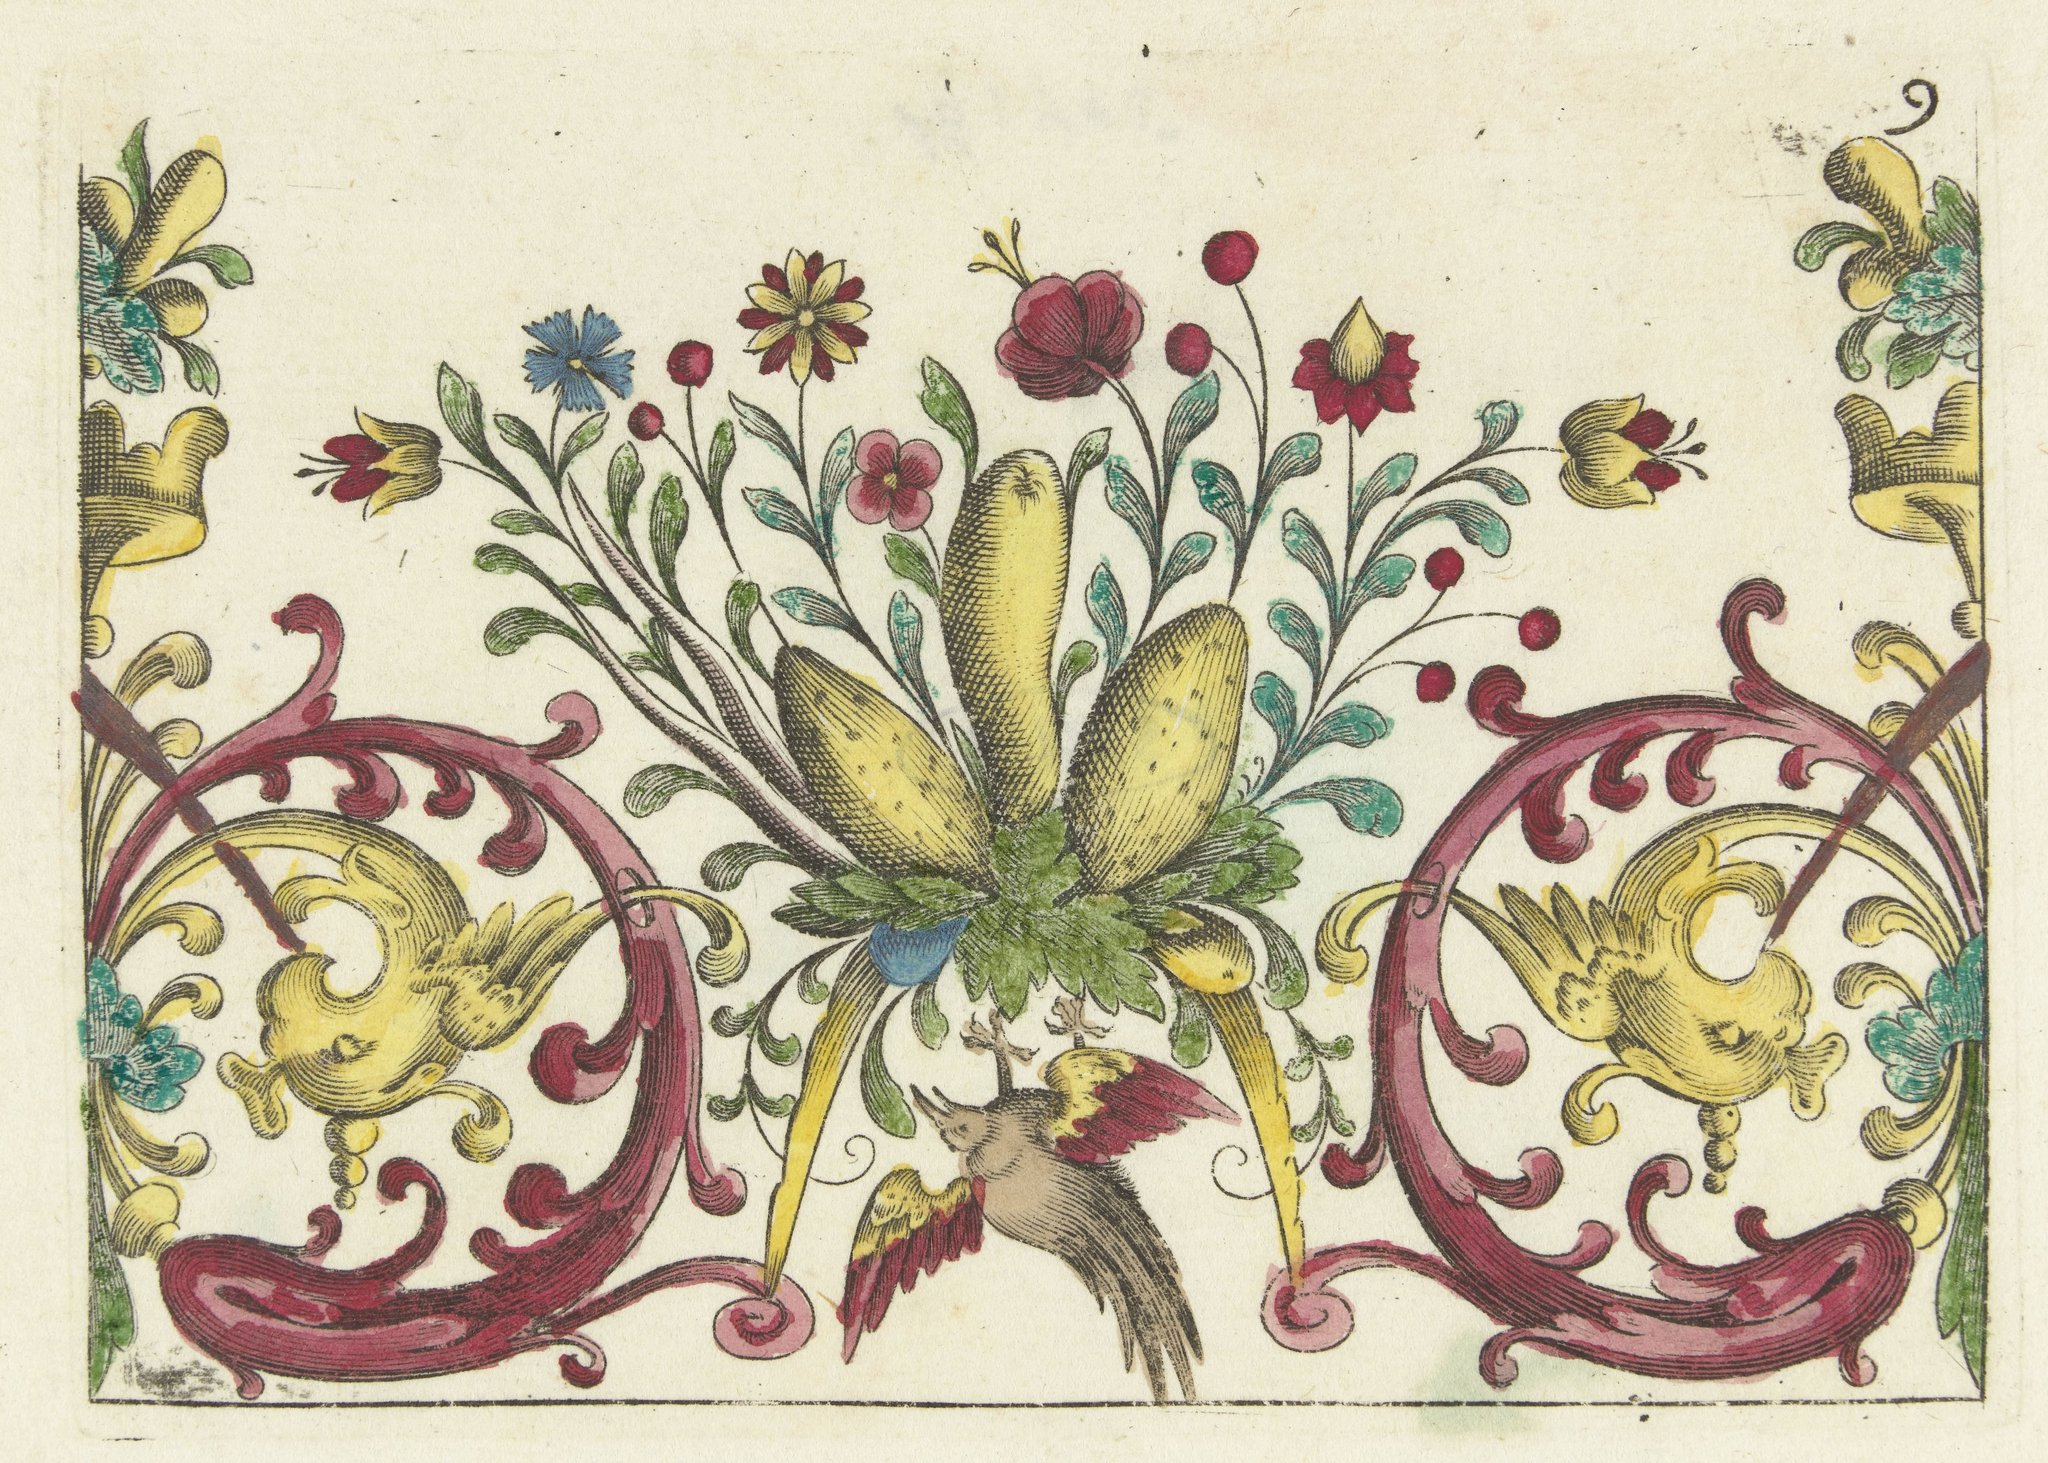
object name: ornament print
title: Vruchtenguirlandes / Früchtenbüchlein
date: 1596-1633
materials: paper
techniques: engraving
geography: germany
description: Vruchten tussen voluten van bladranken die eindigen in gevleugelde vissenkoppen. Titelblad uit een serie van 12 bladen, genummerd 1-8.